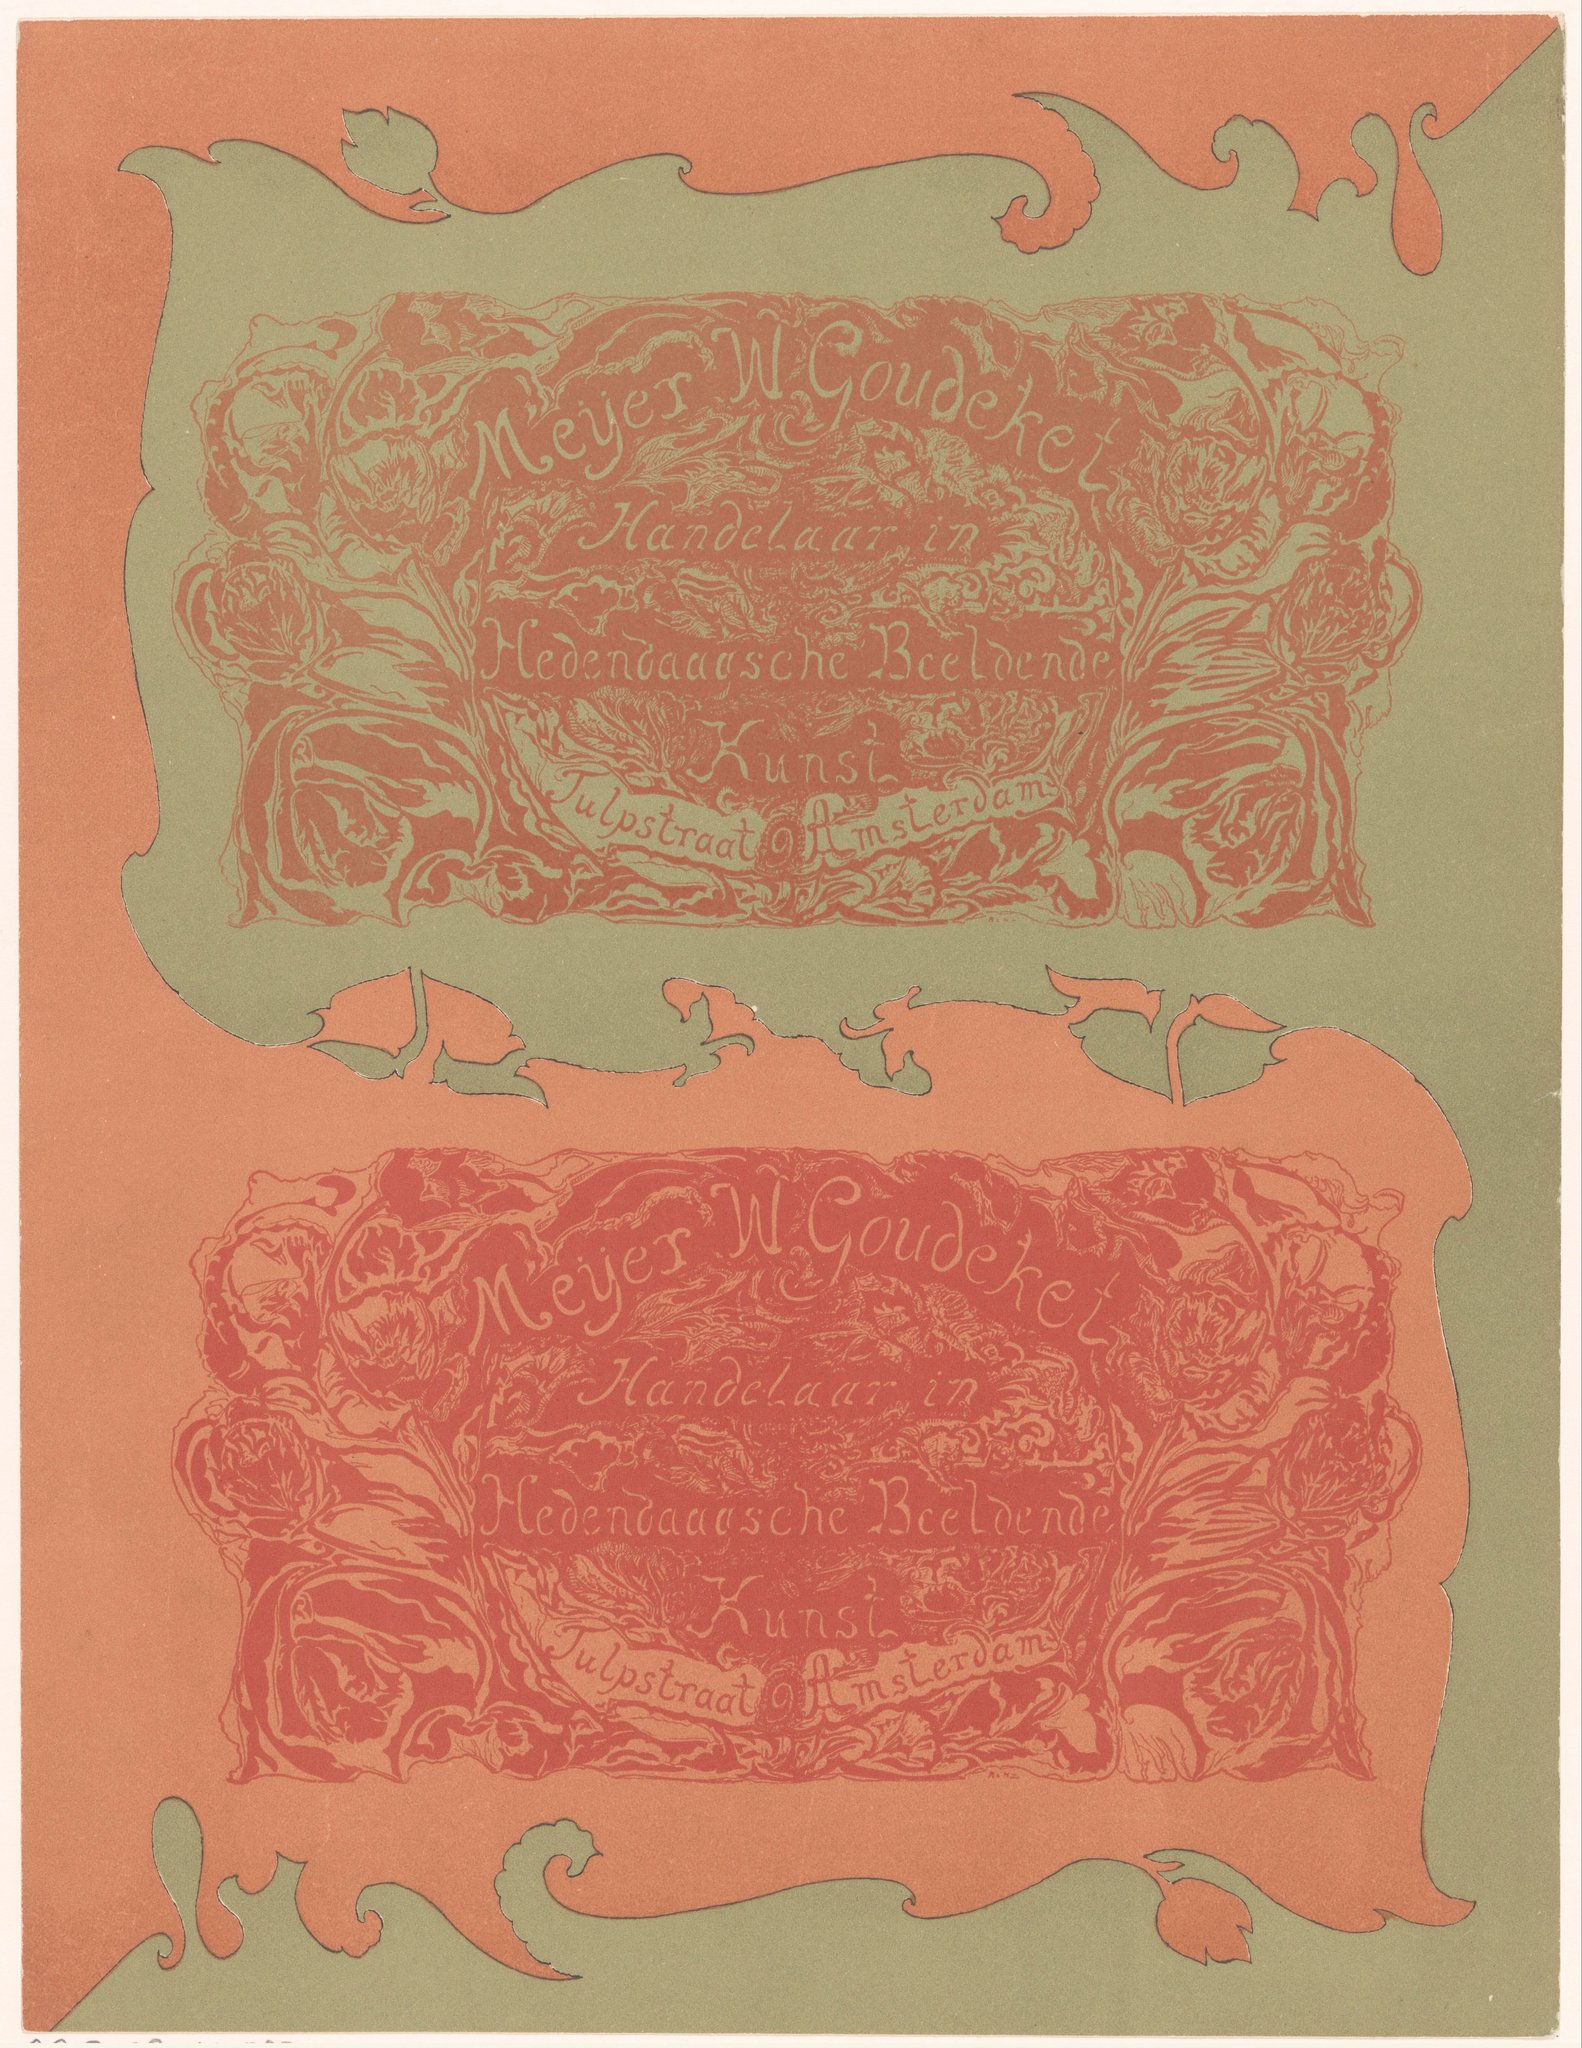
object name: print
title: Advertentie van kunsthandelaar Meijer W. Goudeket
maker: theo colenbrander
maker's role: draughtsman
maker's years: 1841-1930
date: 1896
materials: paper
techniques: lithograph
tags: plants (in general)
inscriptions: : ‘Pl. XVI. Reclamekaart van den kunsthandelaar Meijer W. Goudeket, Tulpstraat 9, Amsterdam, door T.C.A. Colenbrander.’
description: Twee keer de tekst 'Meijer W. Goudeket, Handelaar in Hedendaagsche Beeldende Kunst, Tulpstraat 9 Amsterdam' omhuld door bloemen, bladeren en andere plantmotieven.